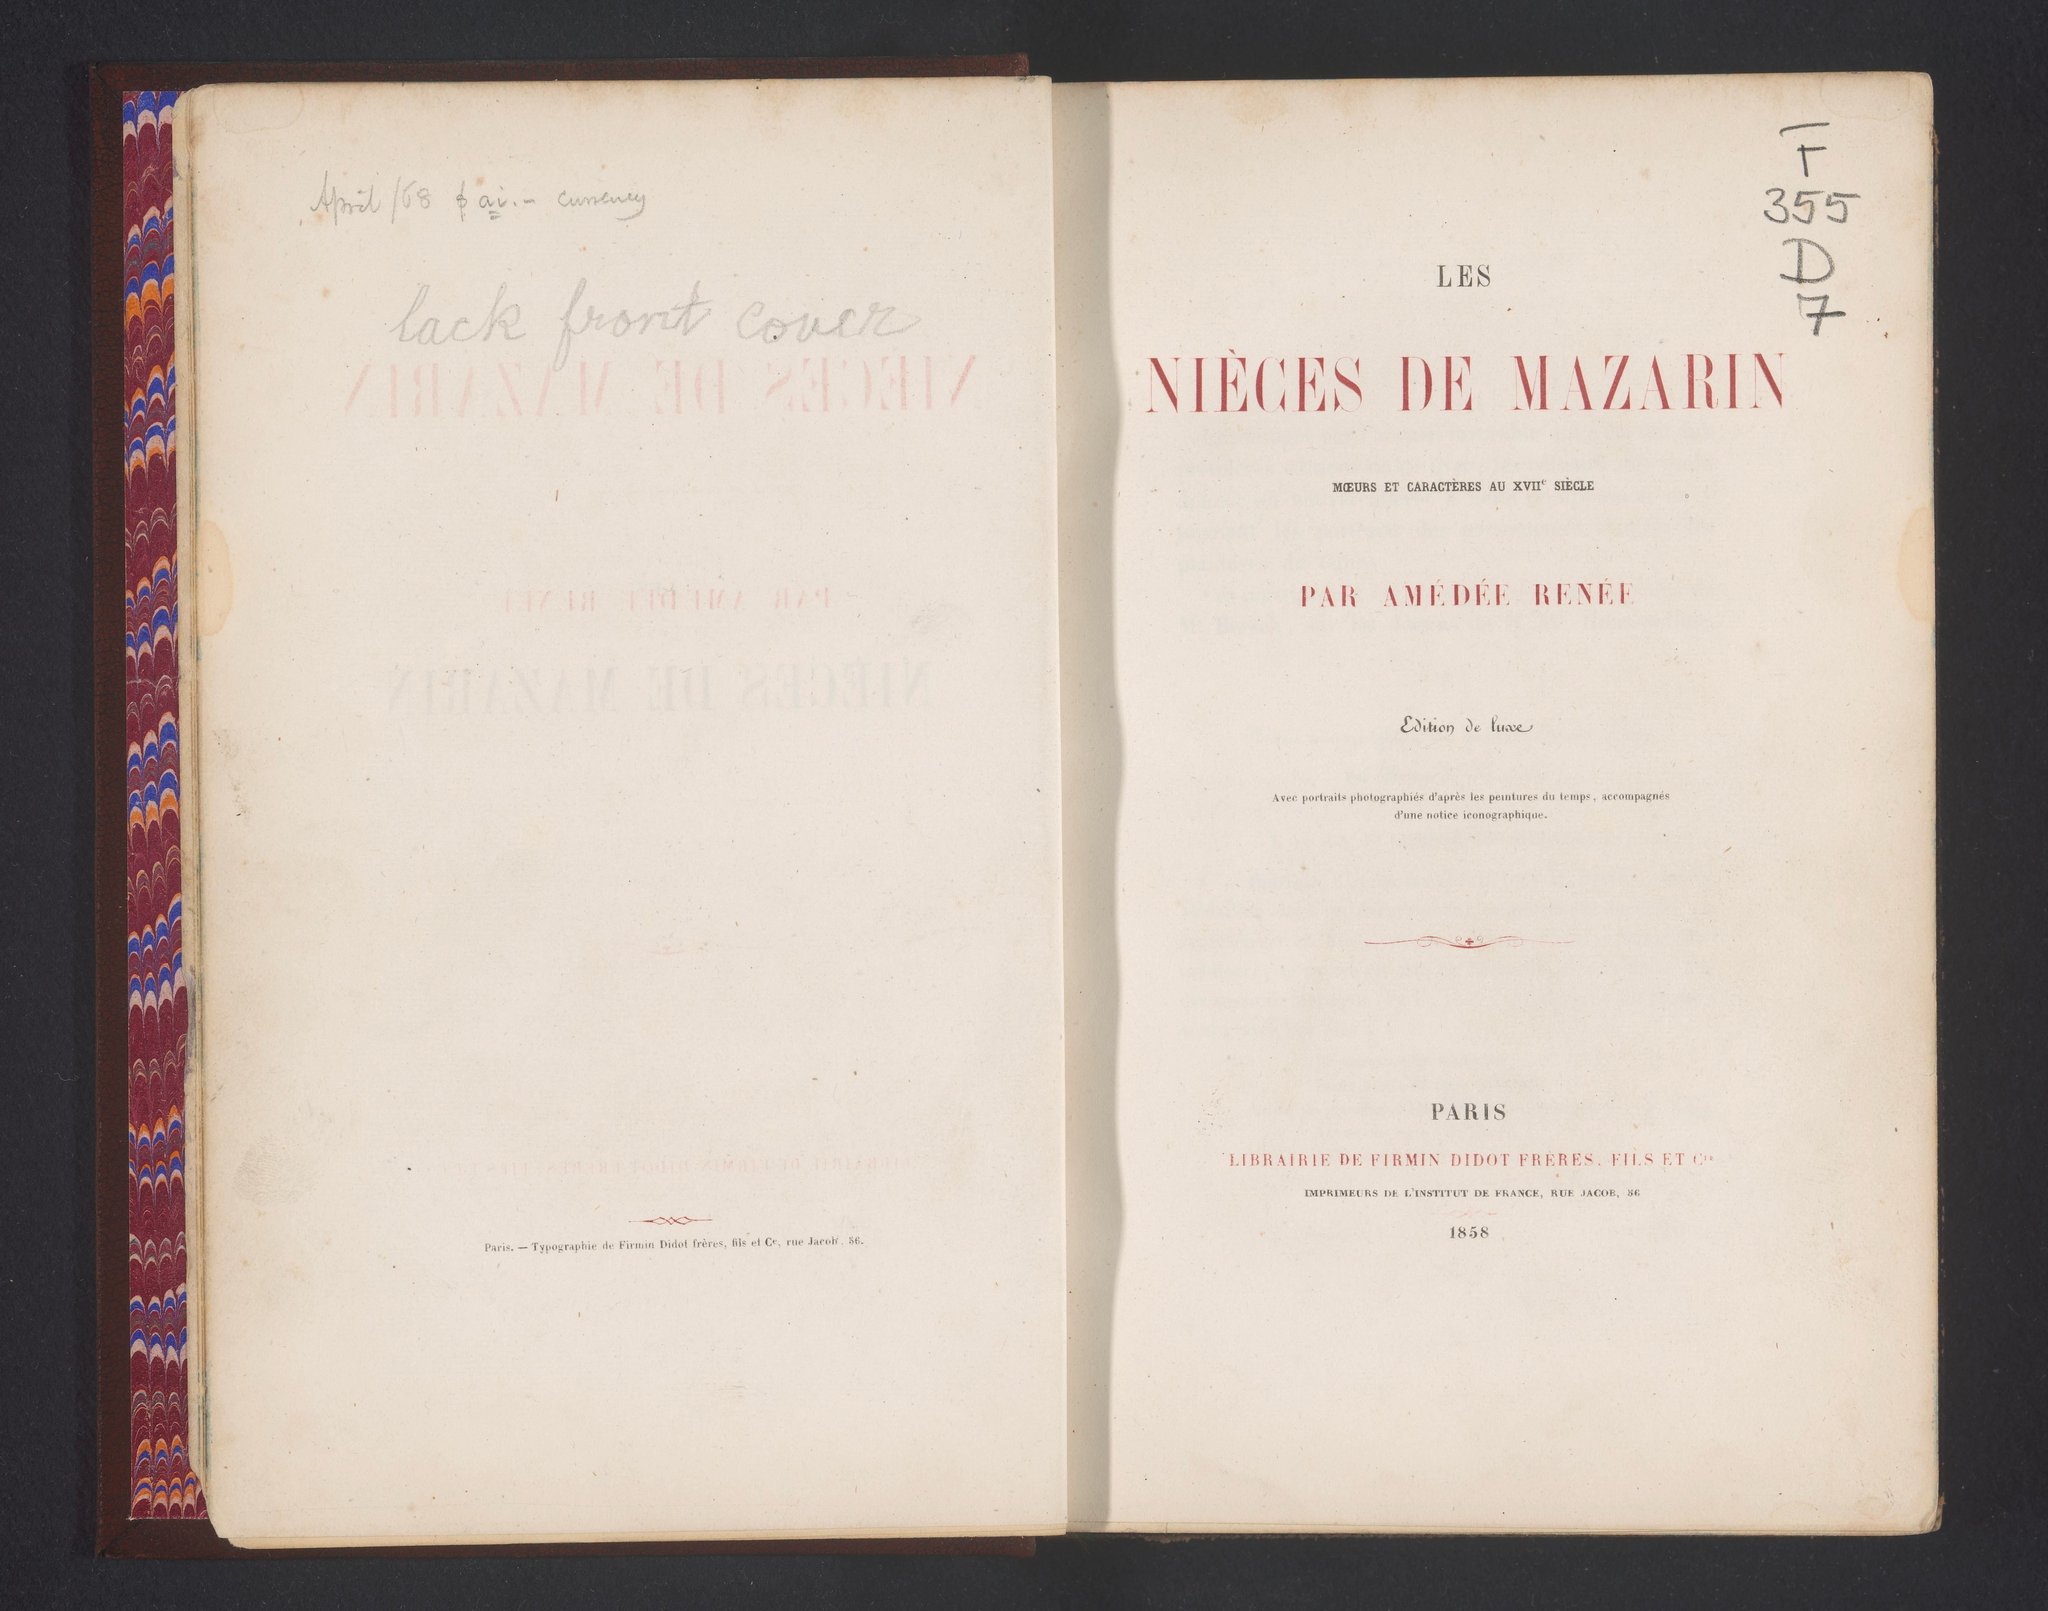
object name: book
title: Les nièces de Mazarin moeurs et caractères au XVIIe siècle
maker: amédée renée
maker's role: publicist, schrijver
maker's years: 1808-1859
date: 1858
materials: leather, paper, photographic support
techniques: marbled paper, marbling, salted paper print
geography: paris